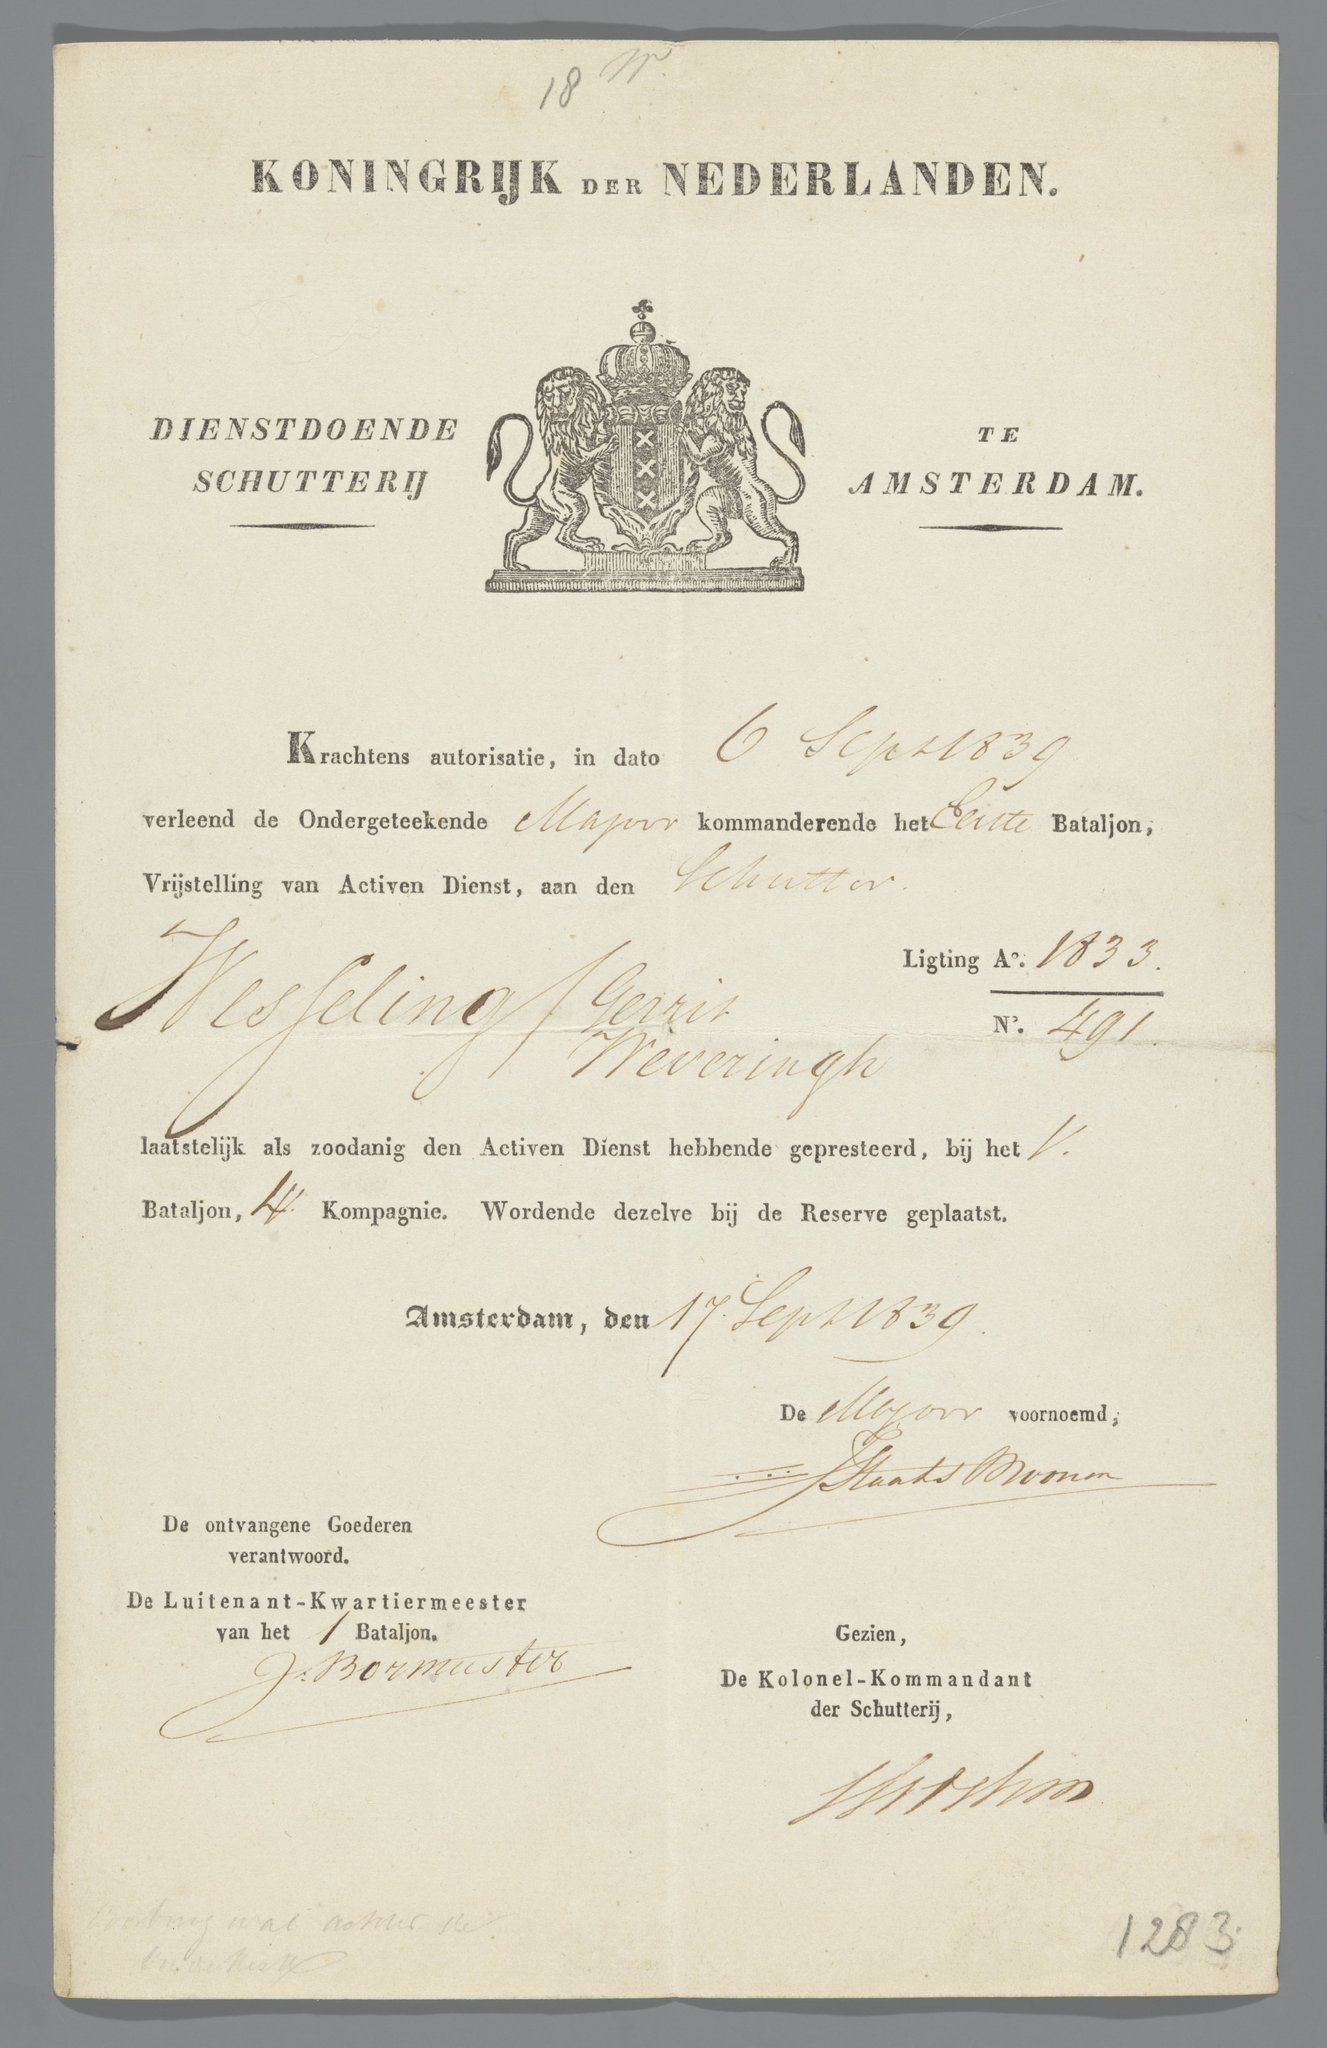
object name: document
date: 1839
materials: ink, paper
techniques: printing, writing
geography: amsterdam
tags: amsterdam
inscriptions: date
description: Document, waarin Wosselings Gerrit Weveringh, schutter te Amsterdam, van actieve dienst wordt vrijgesteld. Gesigneerd en gedateerd.